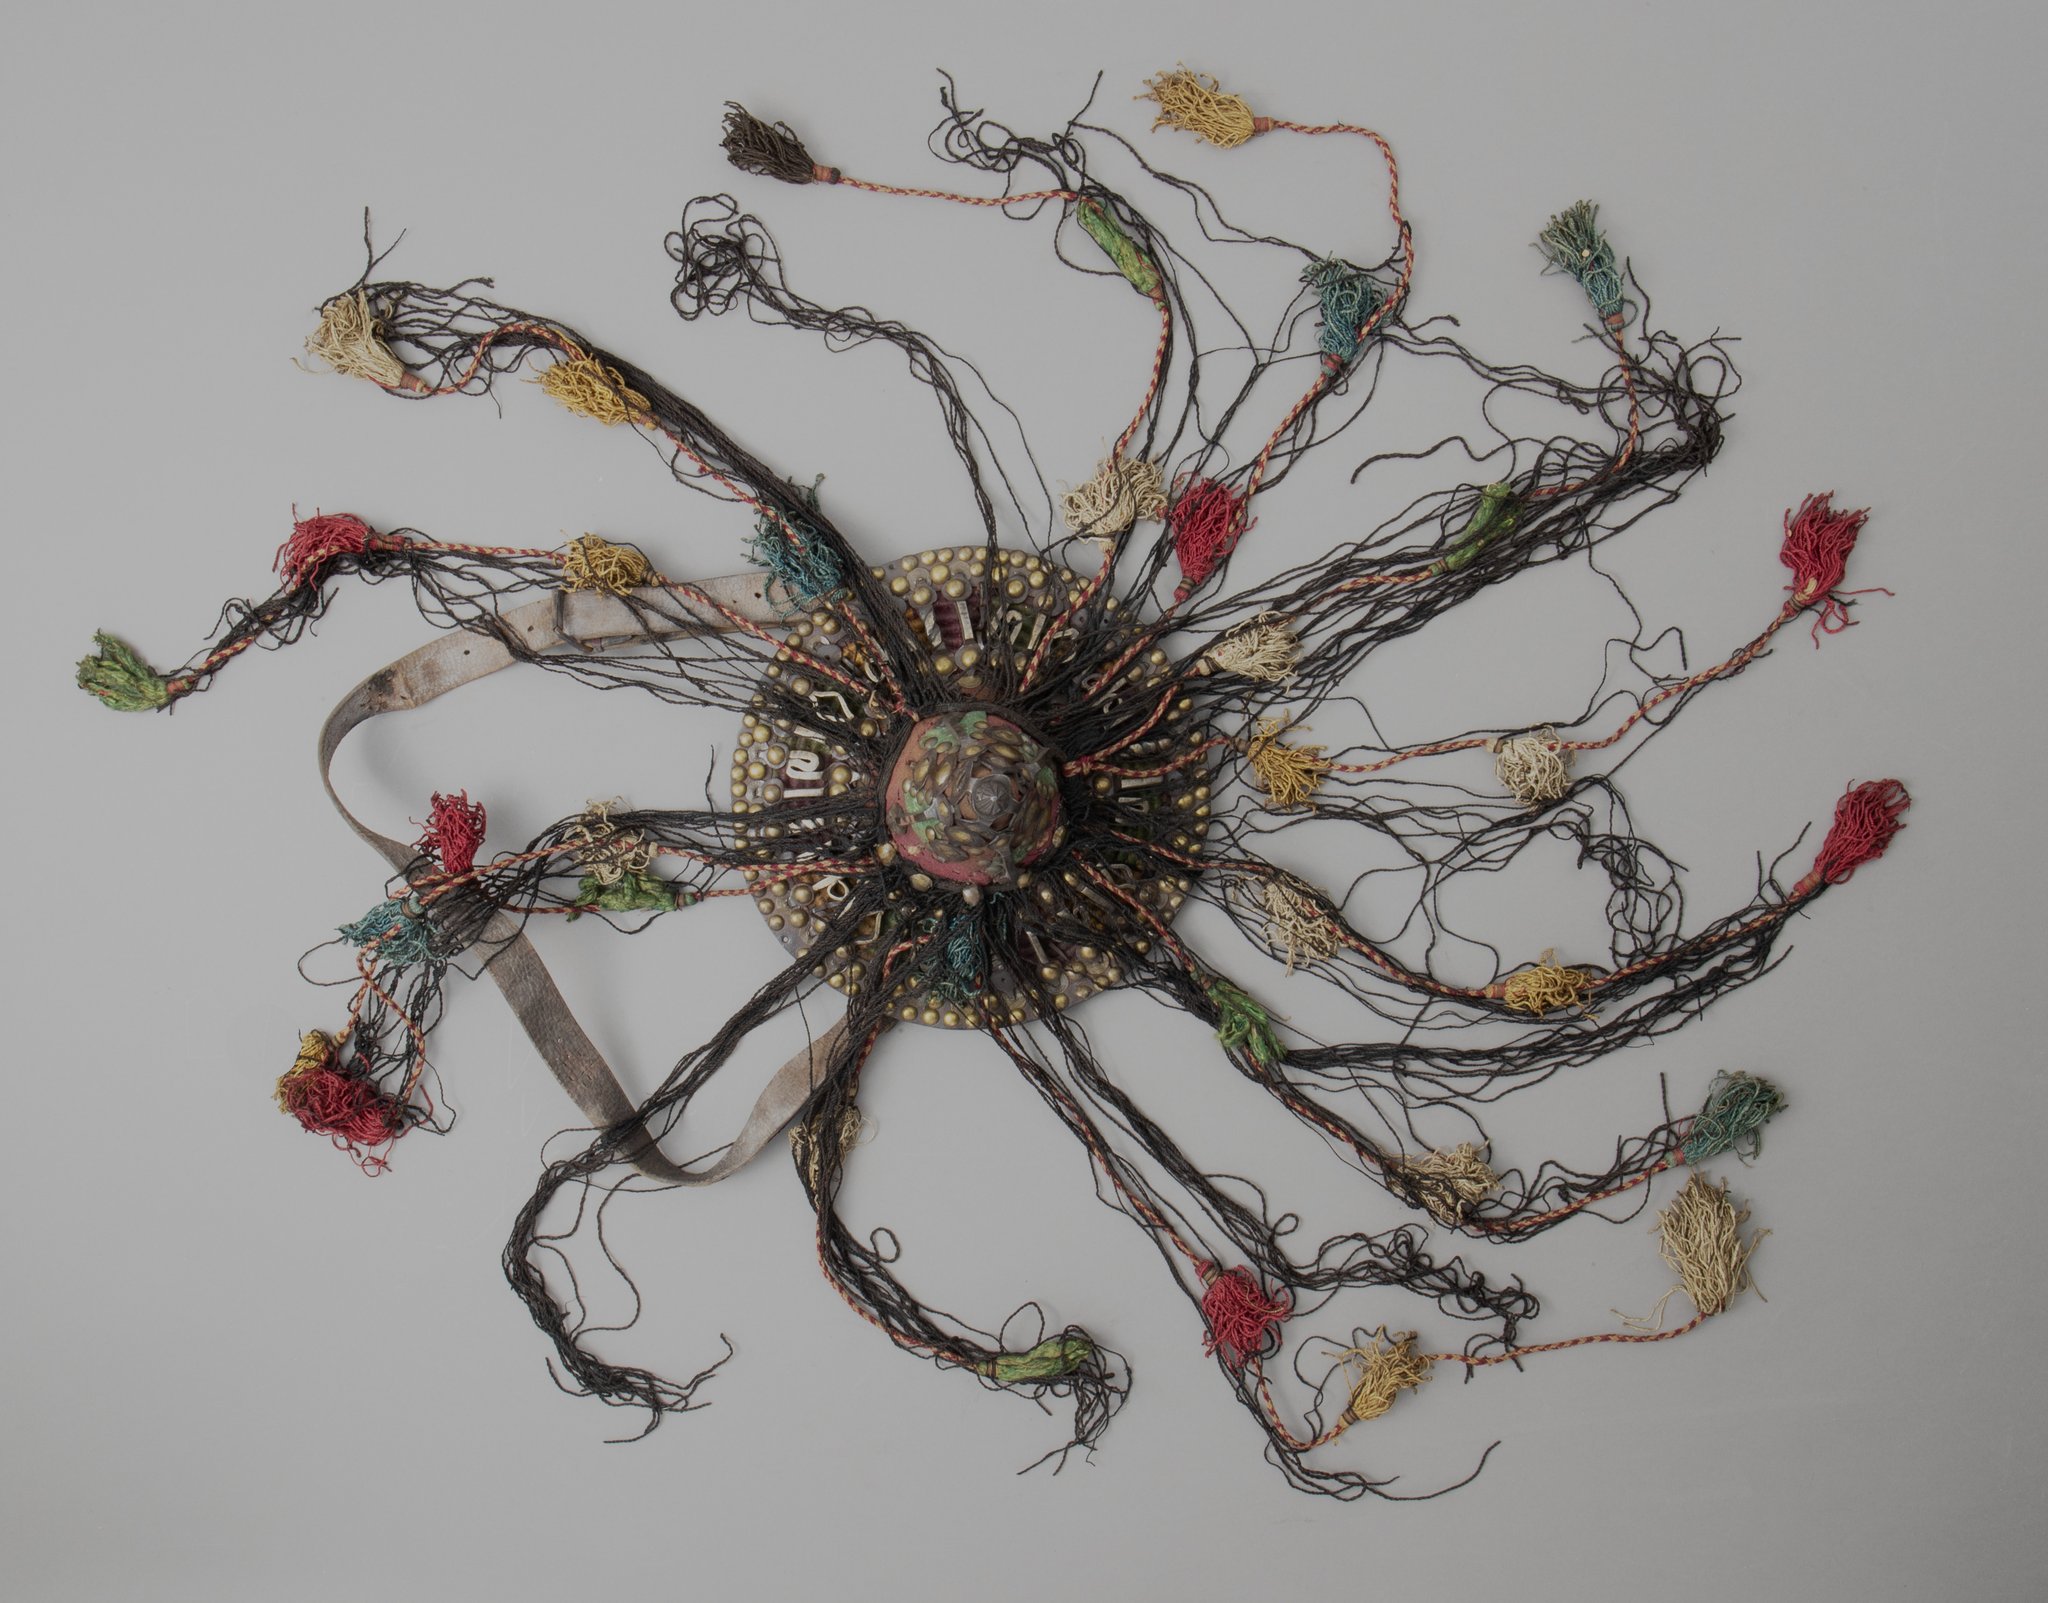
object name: shield dhàl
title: Shield (Dhàl)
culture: indian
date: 1801-1900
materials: brass, cotton, iron, leather, silk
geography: pakistan